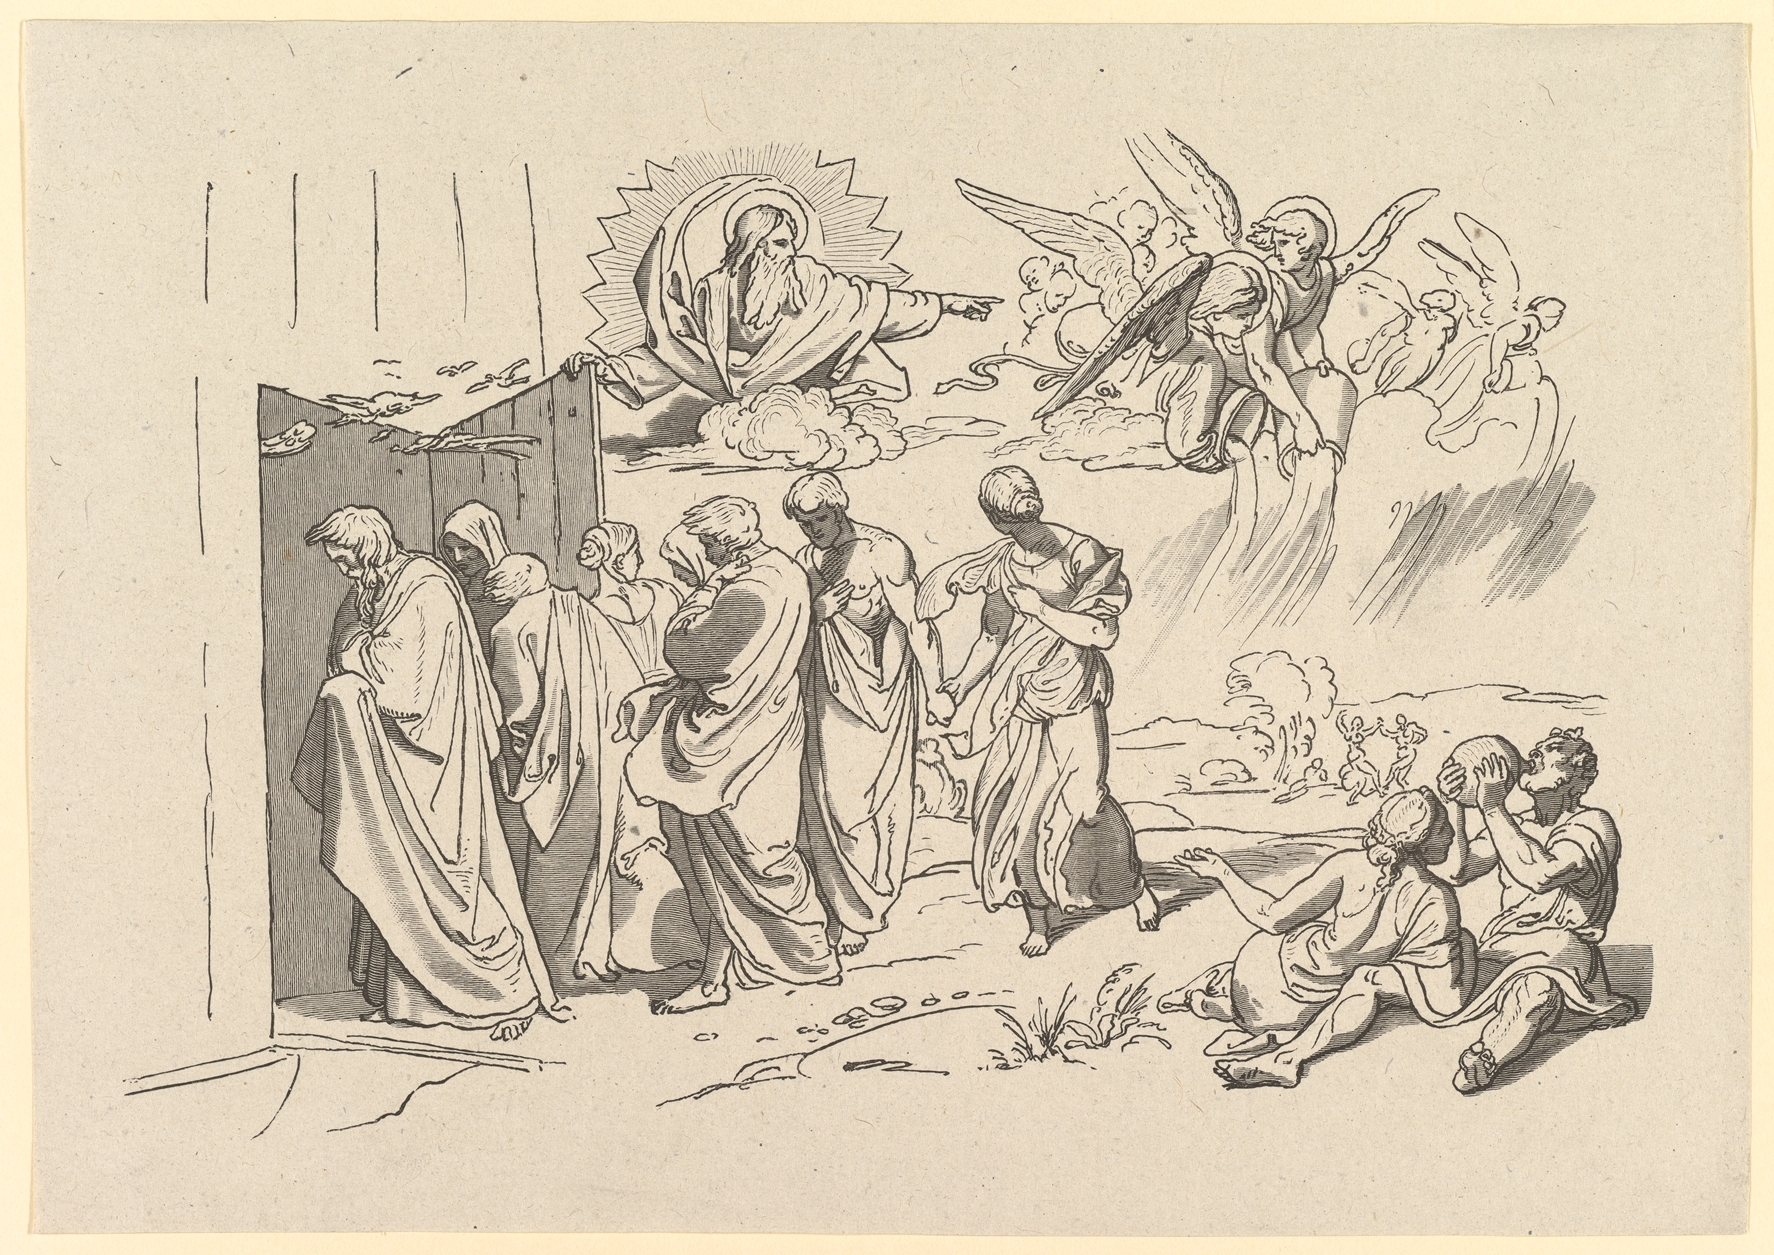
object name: print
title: Gods Summons Noah and His Family into the Ark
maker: joseph von führich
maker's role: artist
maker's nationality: austrian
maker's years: 1800-1876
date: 1827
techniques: engraving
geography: austria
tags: men,women,noah